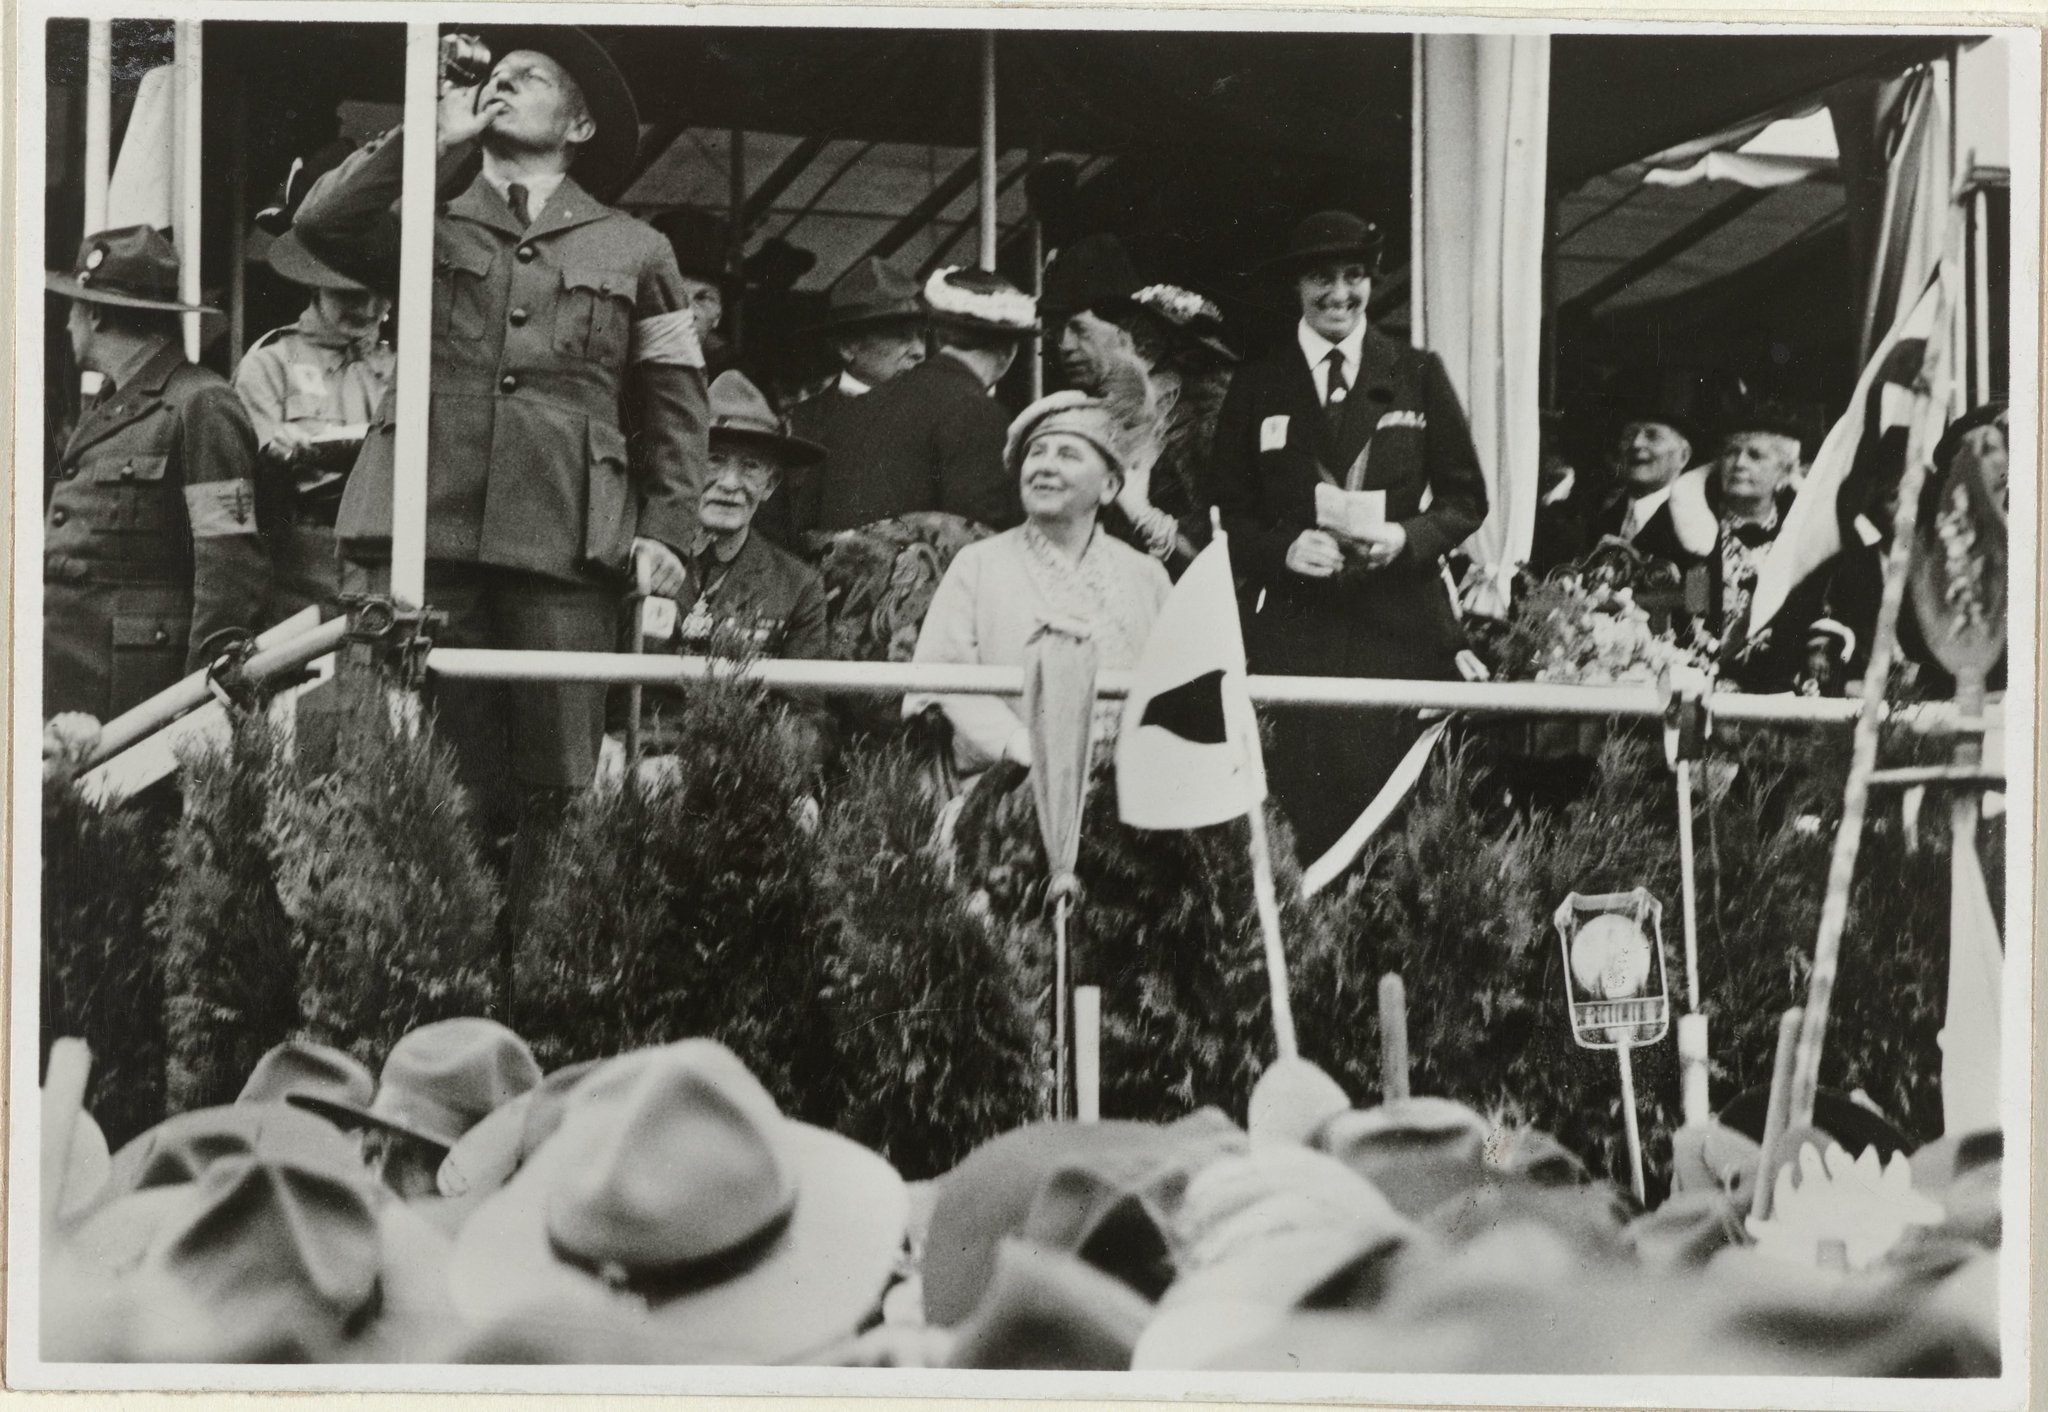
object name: photograph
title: Bezoek van Wilhelmina, koningin der Nederlanden, aan de wereld jamboree op 31 juli 1937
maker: Anonymous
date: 1937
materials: photographic support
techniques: photography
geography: netherlands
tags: the hague, print maker, wilhelmina of the netherlands, london, politician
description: De hier vermelde titel verwijst naar de hoogst verkregen titel van de geportretteerde, niet per se naar de titel die de geportretteerde op deze voorstelling draagt.